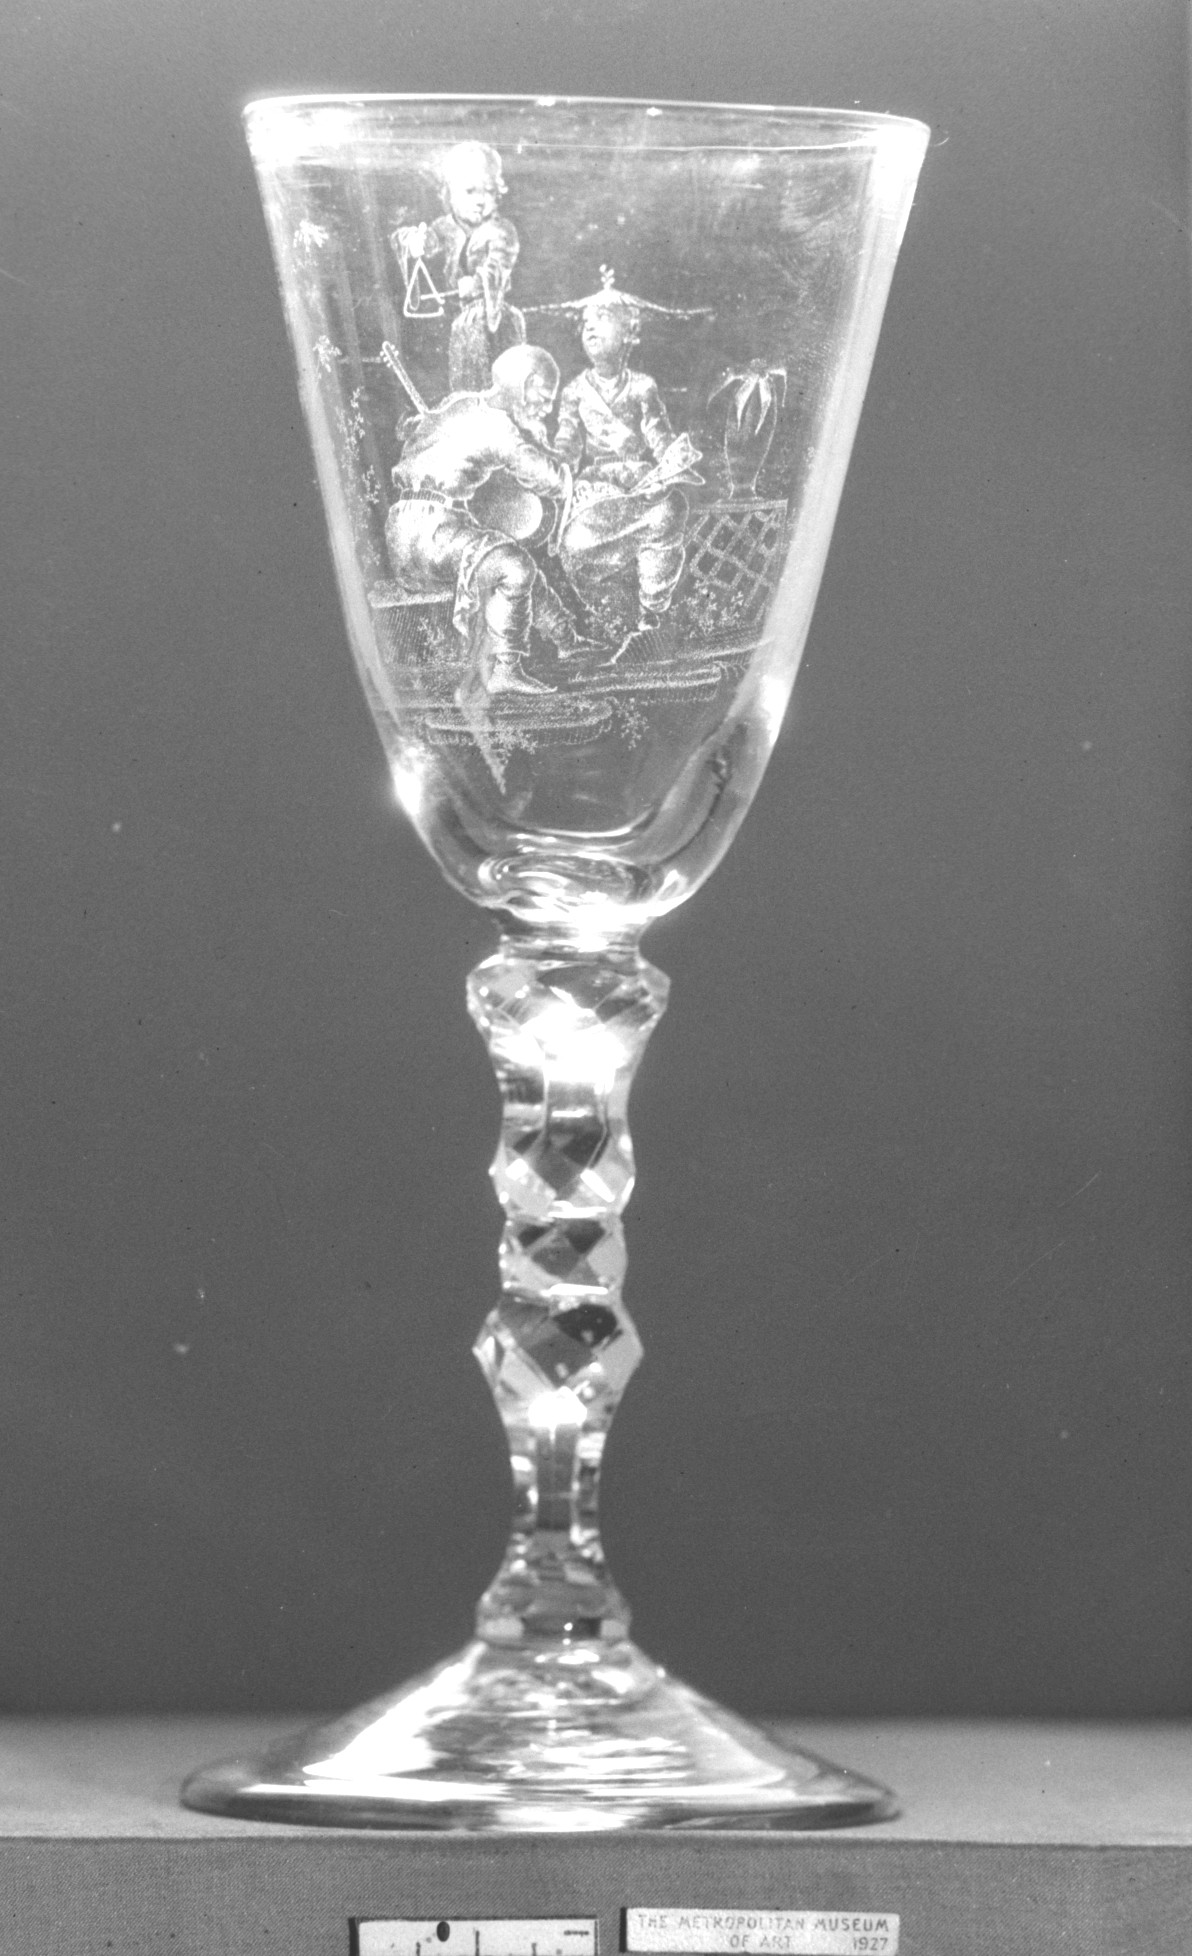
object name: wineglass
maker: david wolff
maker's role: engraver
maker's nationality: dutch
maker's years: 1732-1798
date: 1780-1785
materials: glass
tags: boys,men